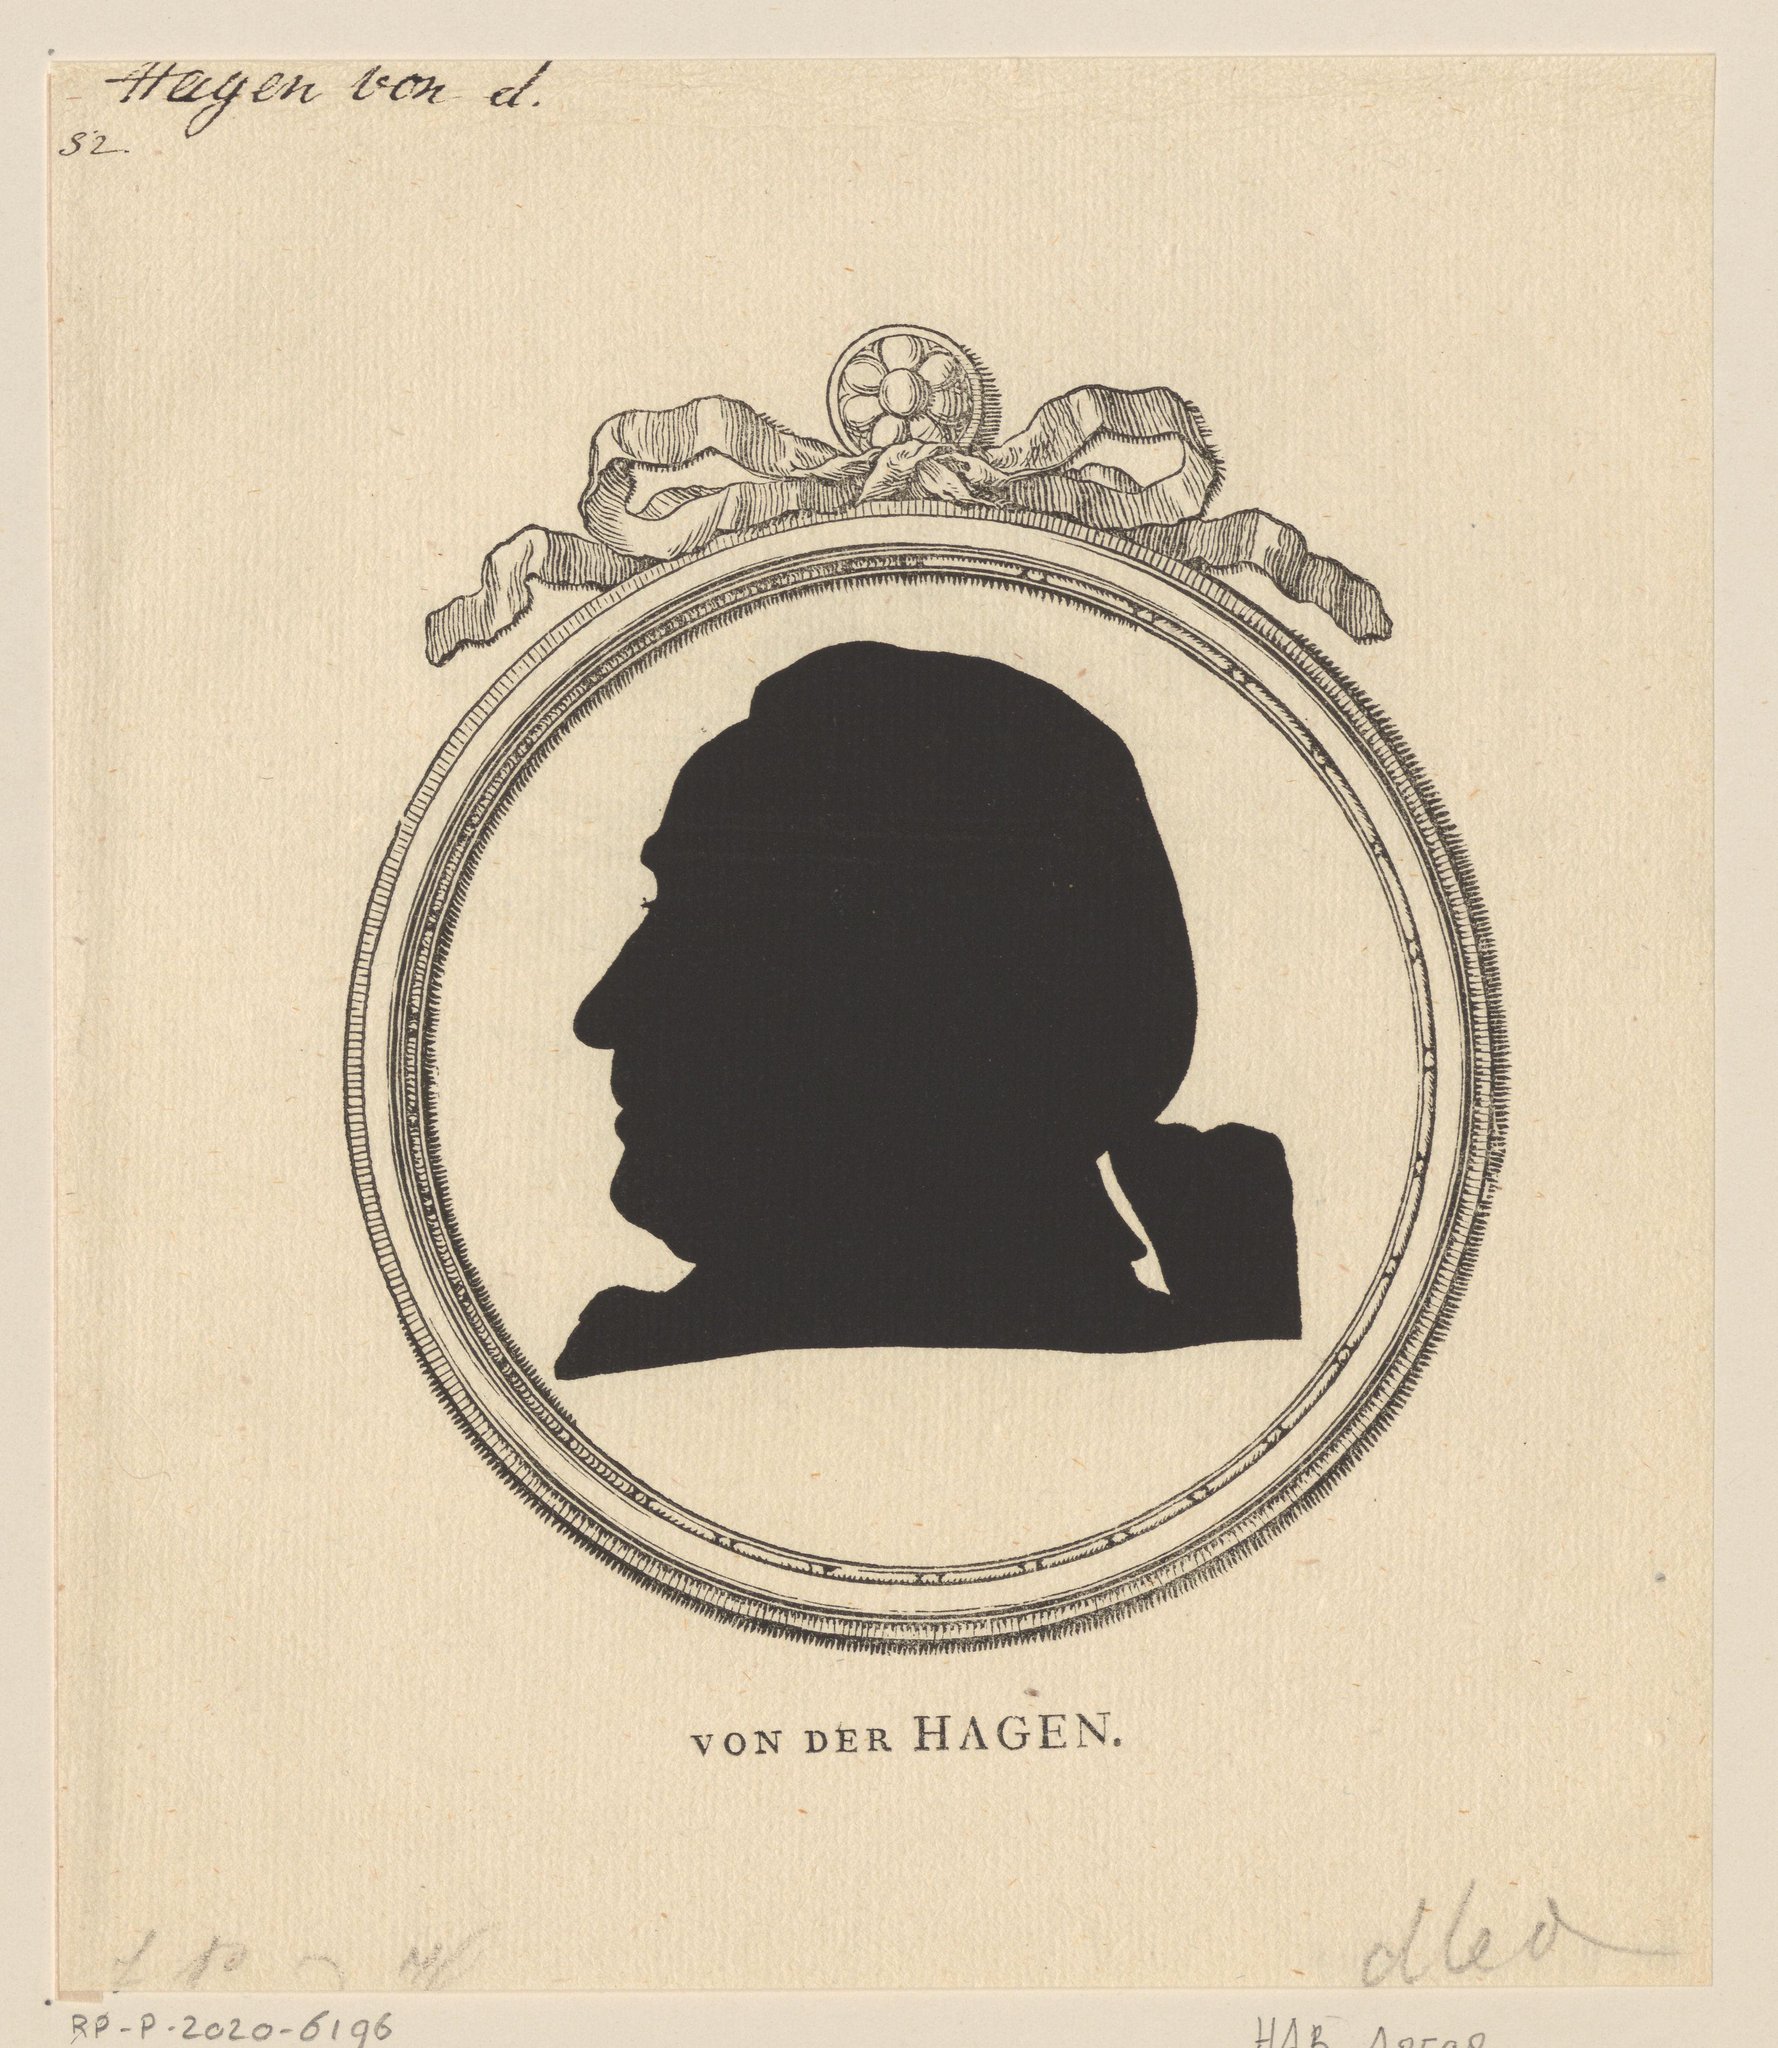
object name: print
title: Silhouetportret van Thomas Philipp von der Hagen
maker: Anonymous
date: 1750-1799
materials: paper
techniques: letterpress printing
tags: berlin, historical persons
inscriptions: inscription: ‘Hagen von d.’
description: Prent mogelijk uit: Unger, Johann Friedrich. Schattenrisse von Berlinischen Gelehrten. Dritte Sammlung. Berlijn: s.n., 1779.